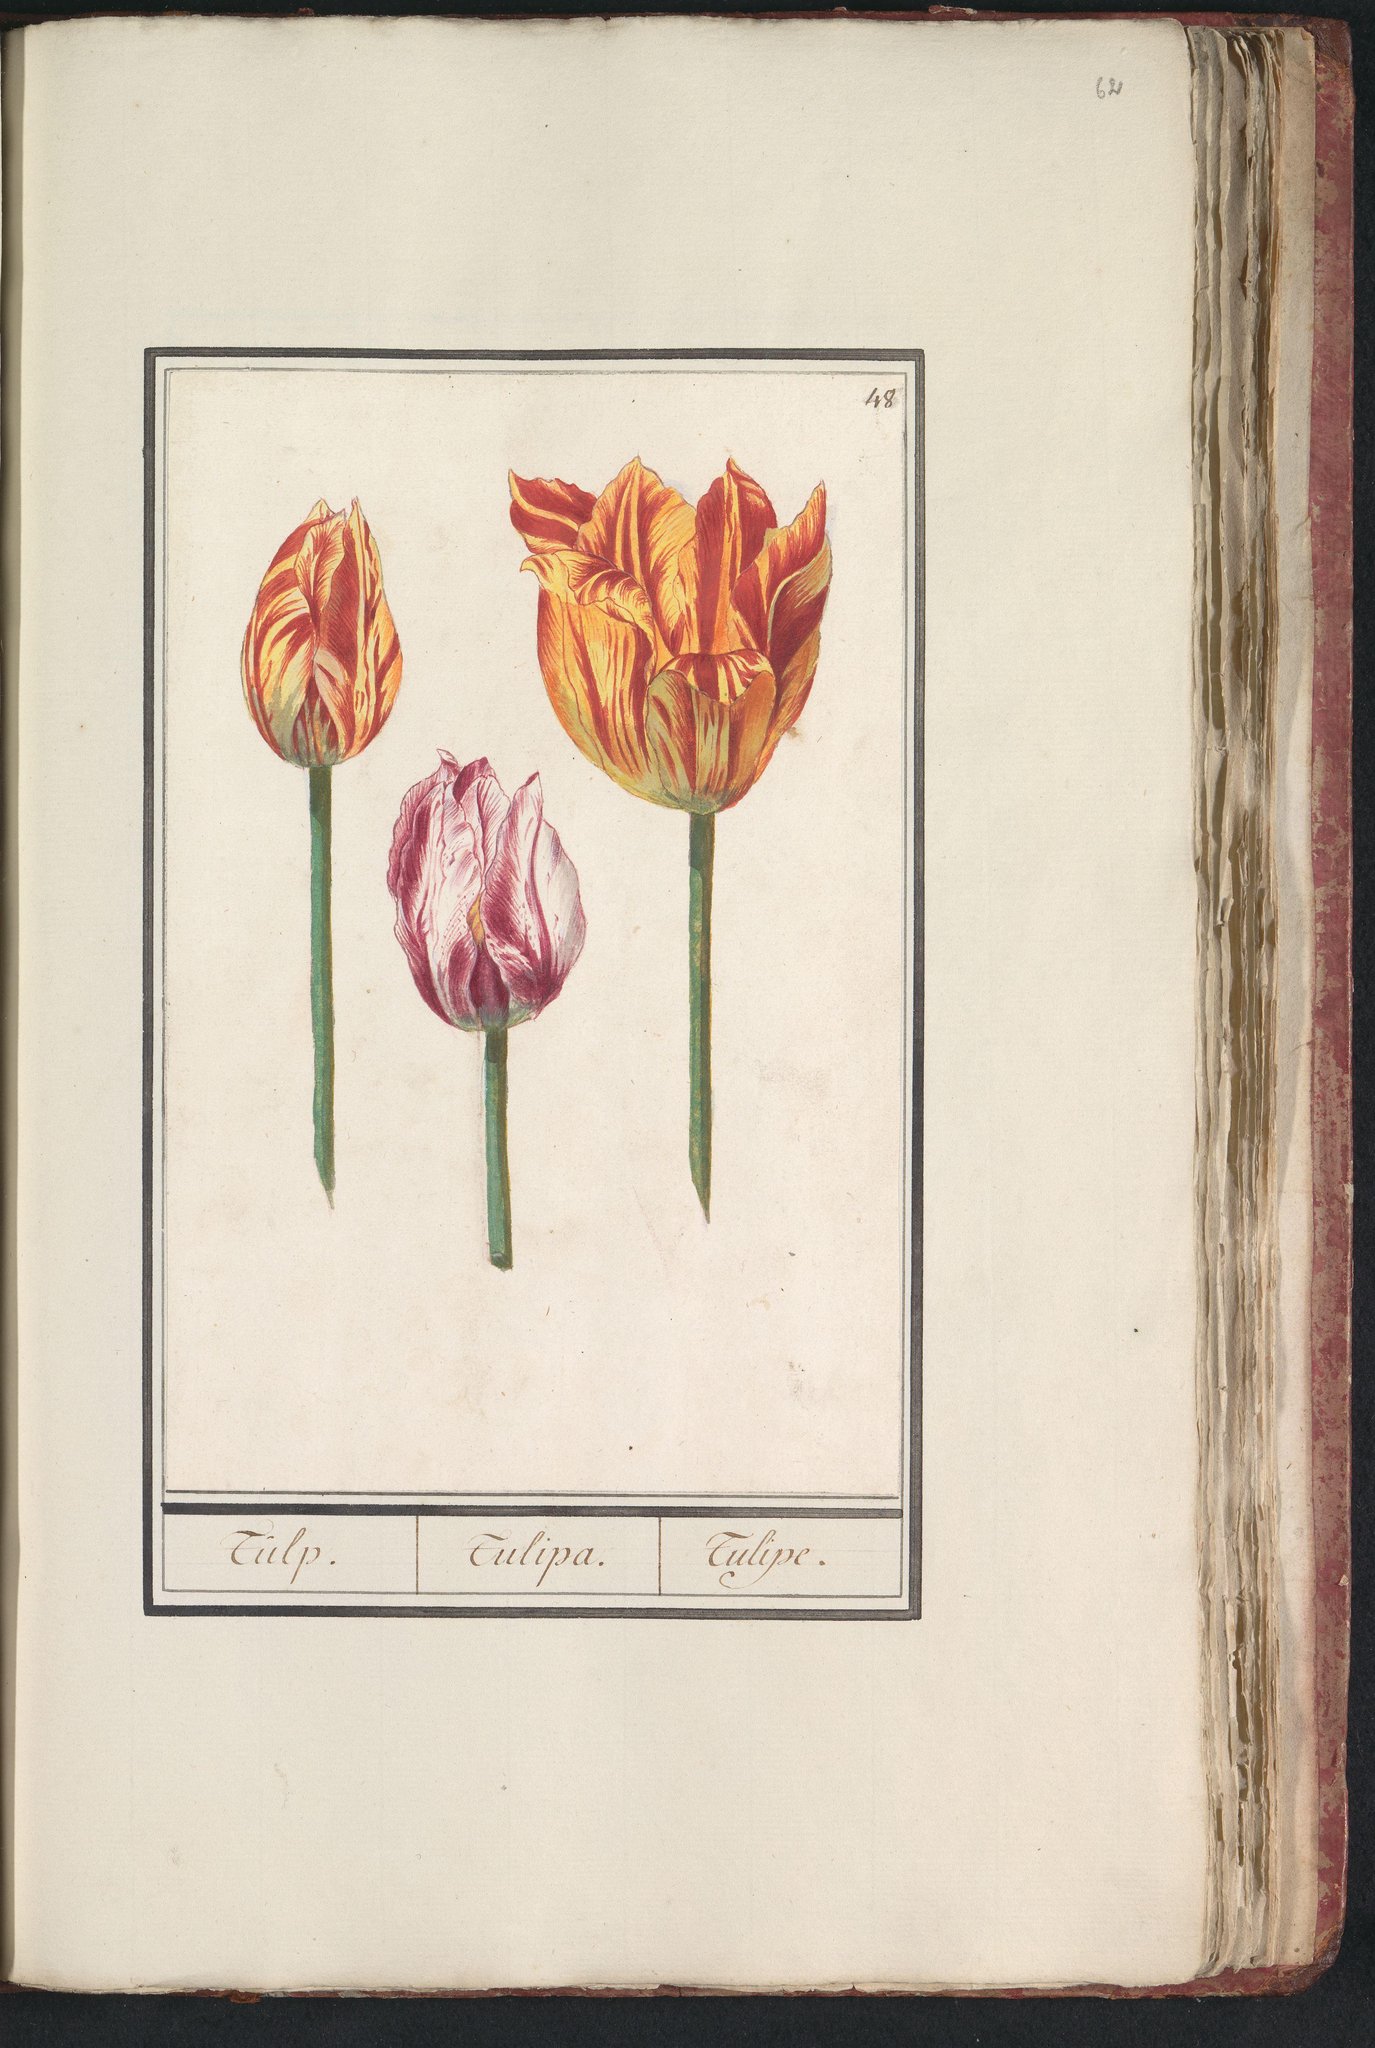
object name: drawing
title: Tulp. / Tulipa. / Tulipe.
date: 1596-1610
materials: chalk, paint, paper, watercolor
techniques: brush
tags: flowers: tulip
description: Twee geel-rode en een wit-rode tulp. Genummerd rechtsboven: 48. Onderdeel van het eerste album met tekeningen van bloemen en planten. Achtste van twaalf albums met tekeningen van dieren, vogels en planten bekend rond 1600, gemaakt in opdracht van keizer Rudolf II. Met toelichting in Nederlands, Latijn en Frans.